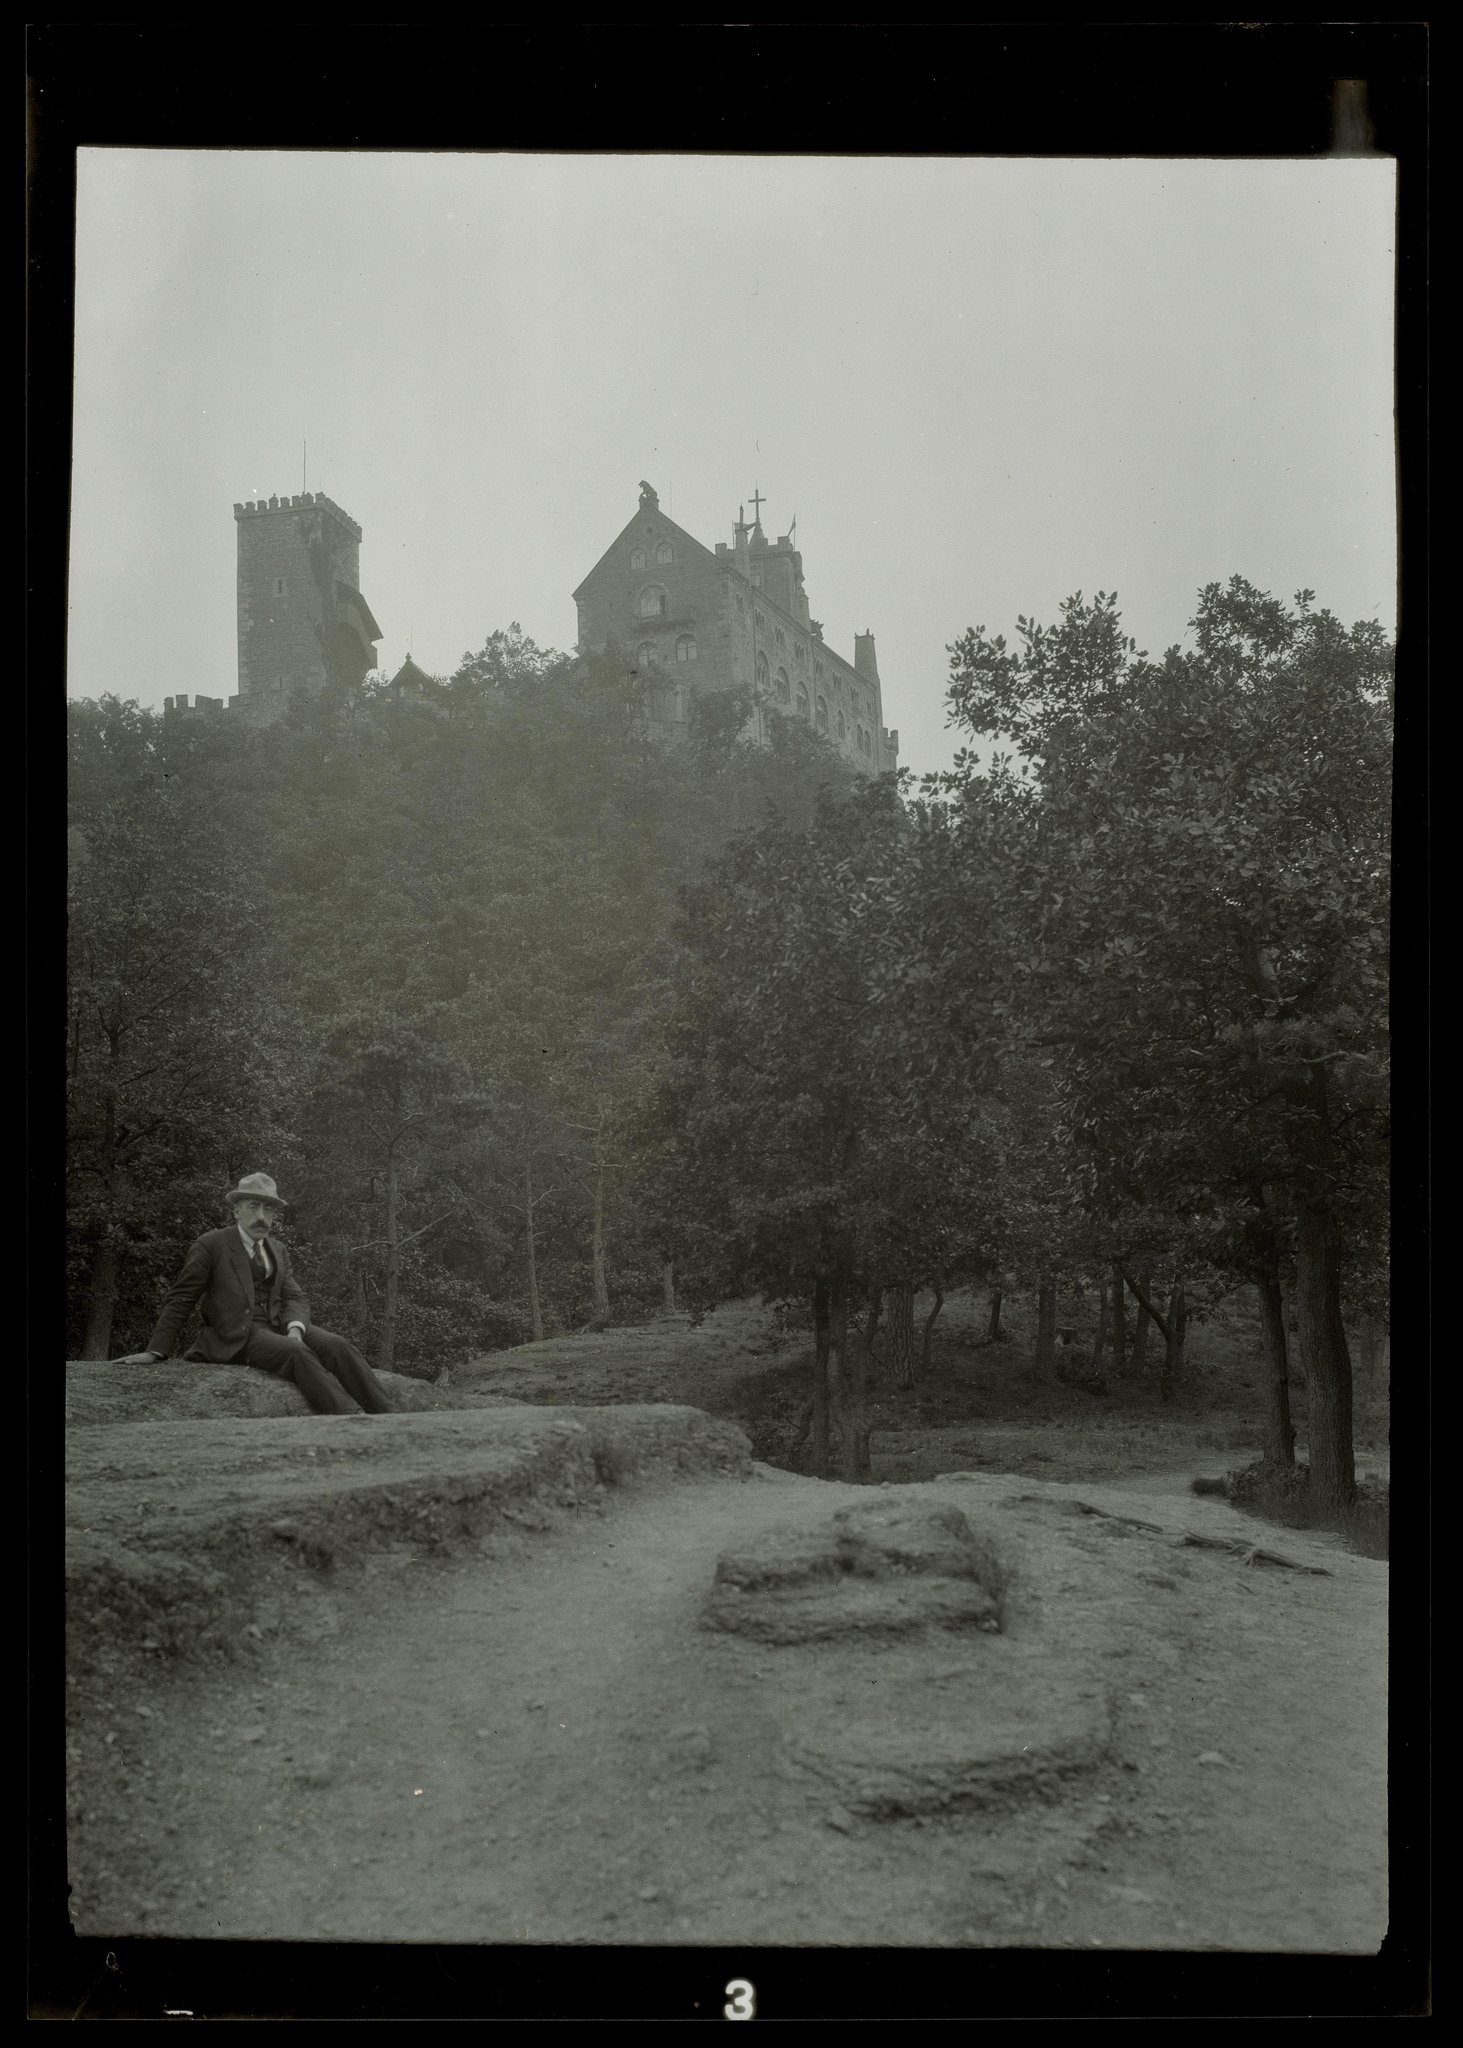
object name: photograph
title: Filmnegatief met opname van Eisenach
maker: Anonymous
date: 1921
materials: film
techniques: gelatin silver negative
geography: germany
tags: eisenach